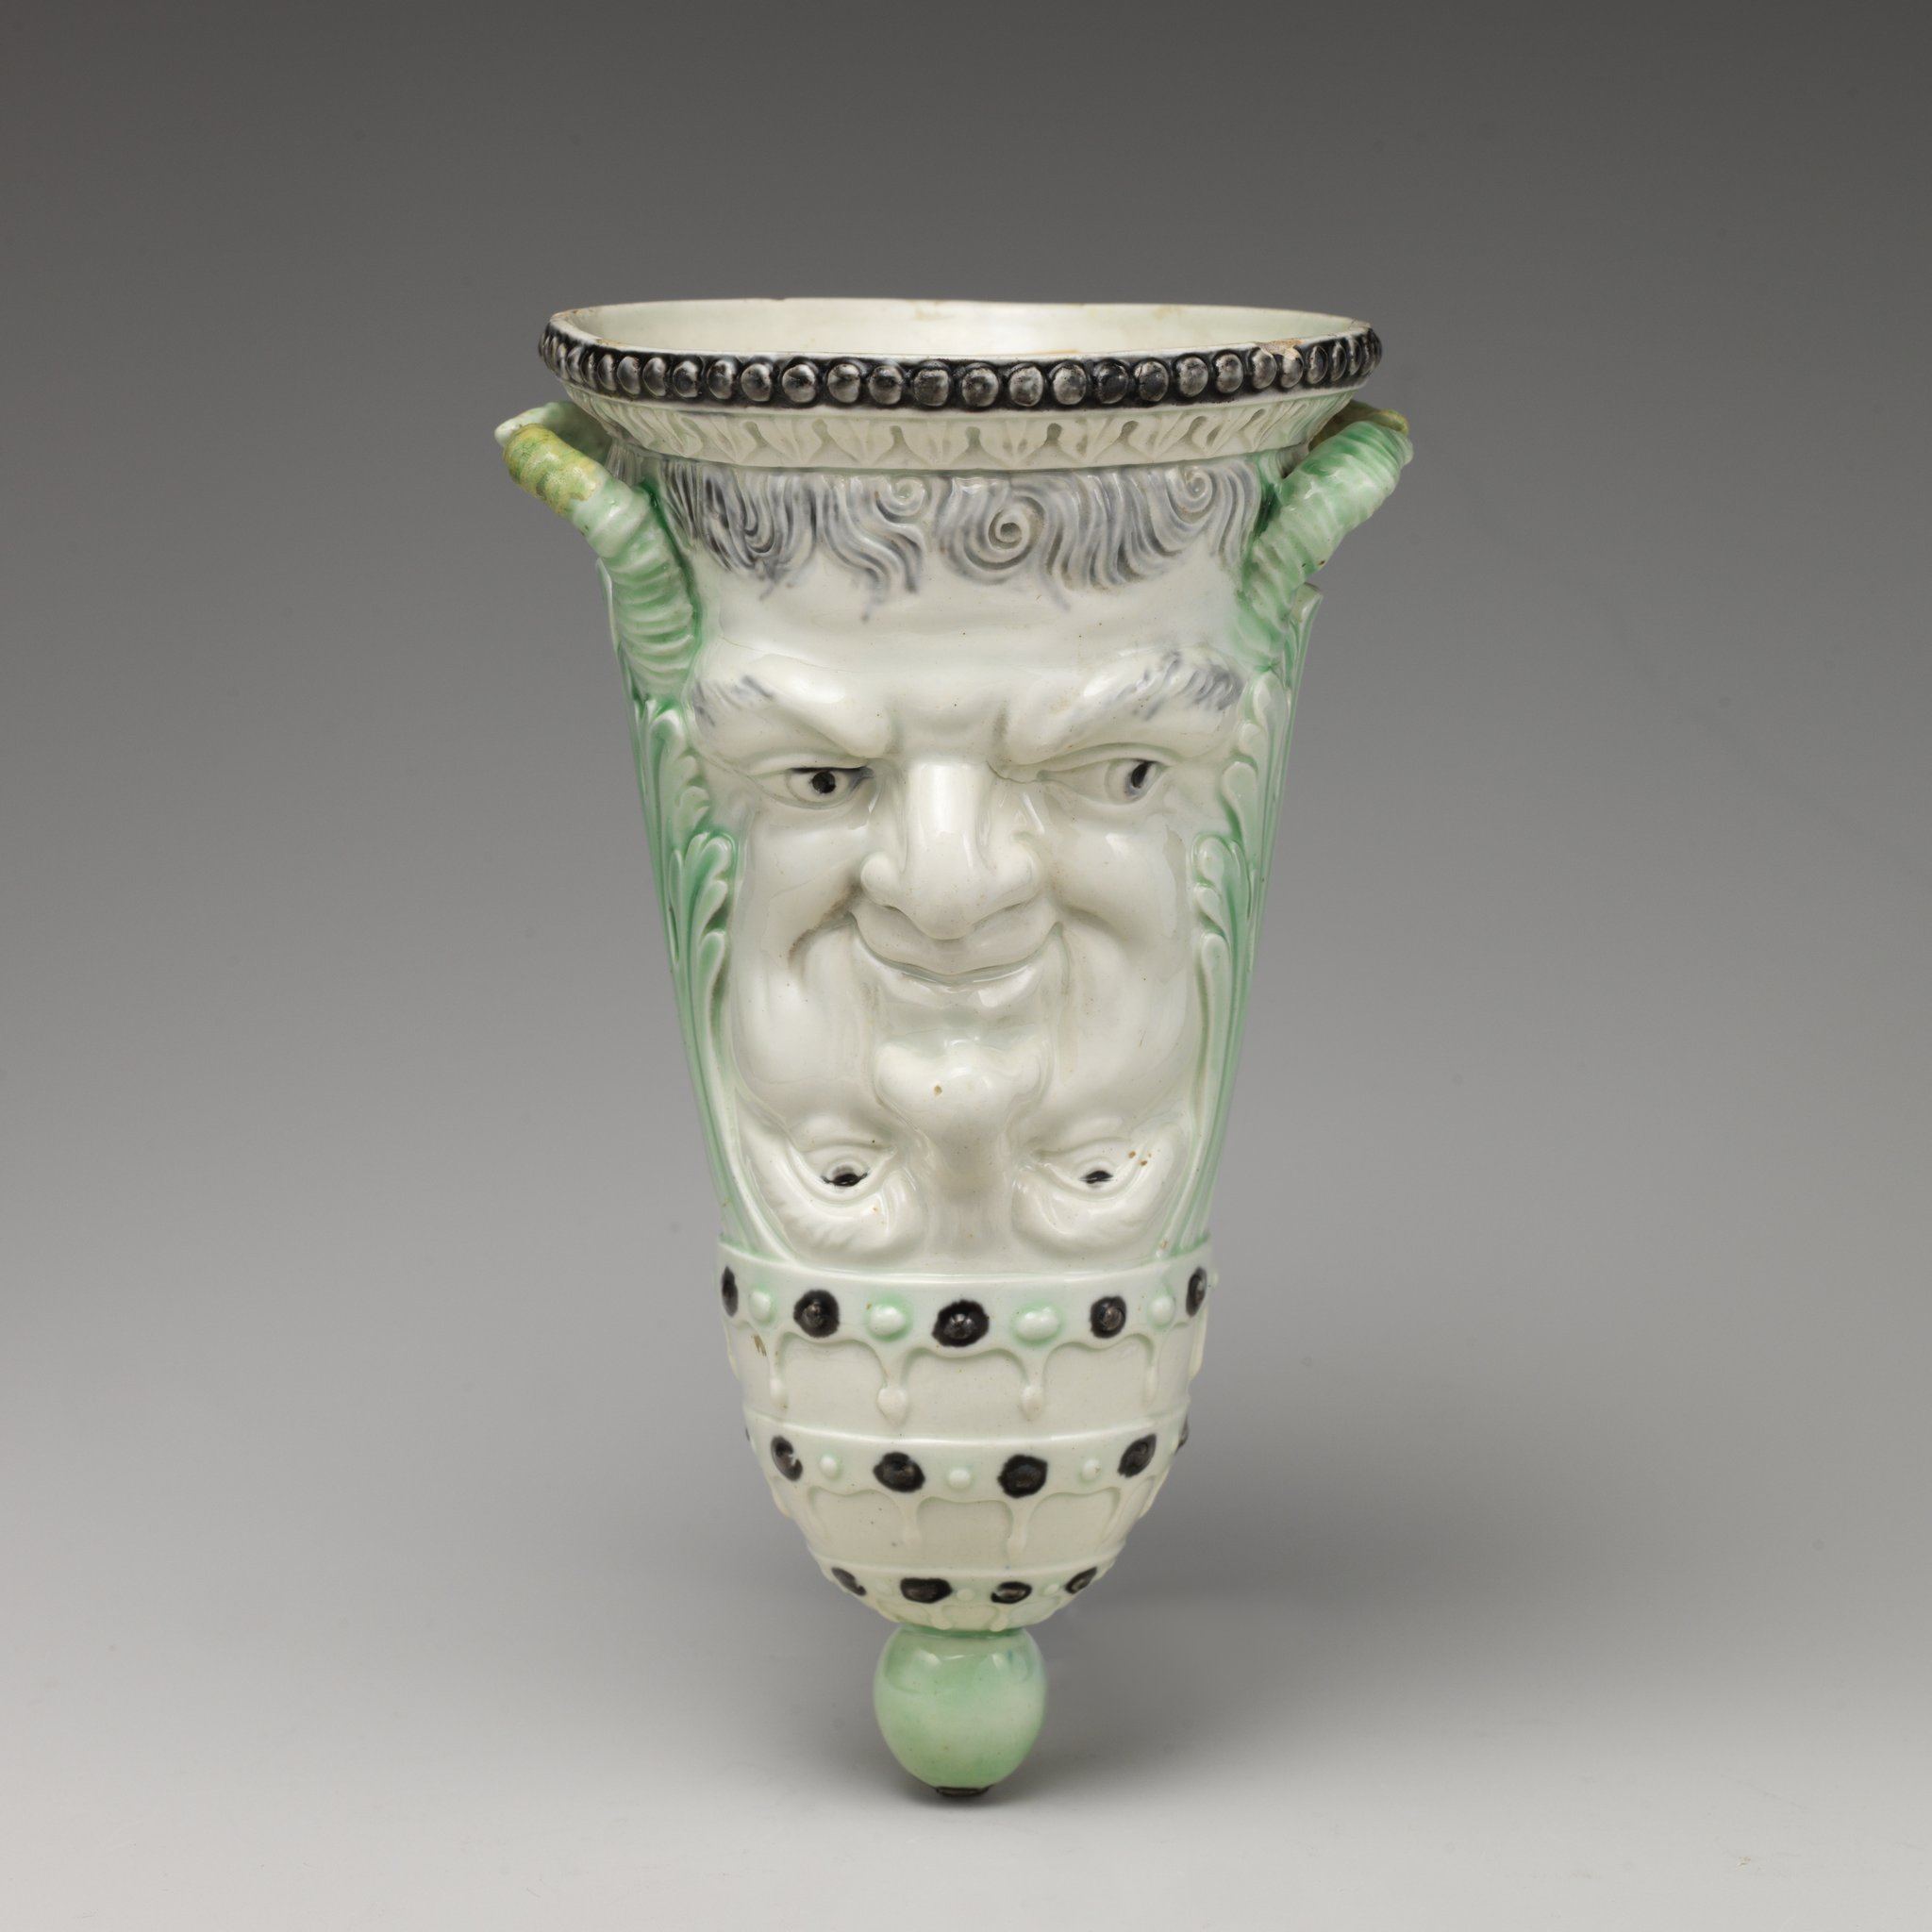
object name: stirrup cup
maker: ralph wood the younger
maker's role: maker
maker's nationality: british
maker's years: 1748-1795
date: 1780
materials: earthenware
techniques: glazing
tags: faces